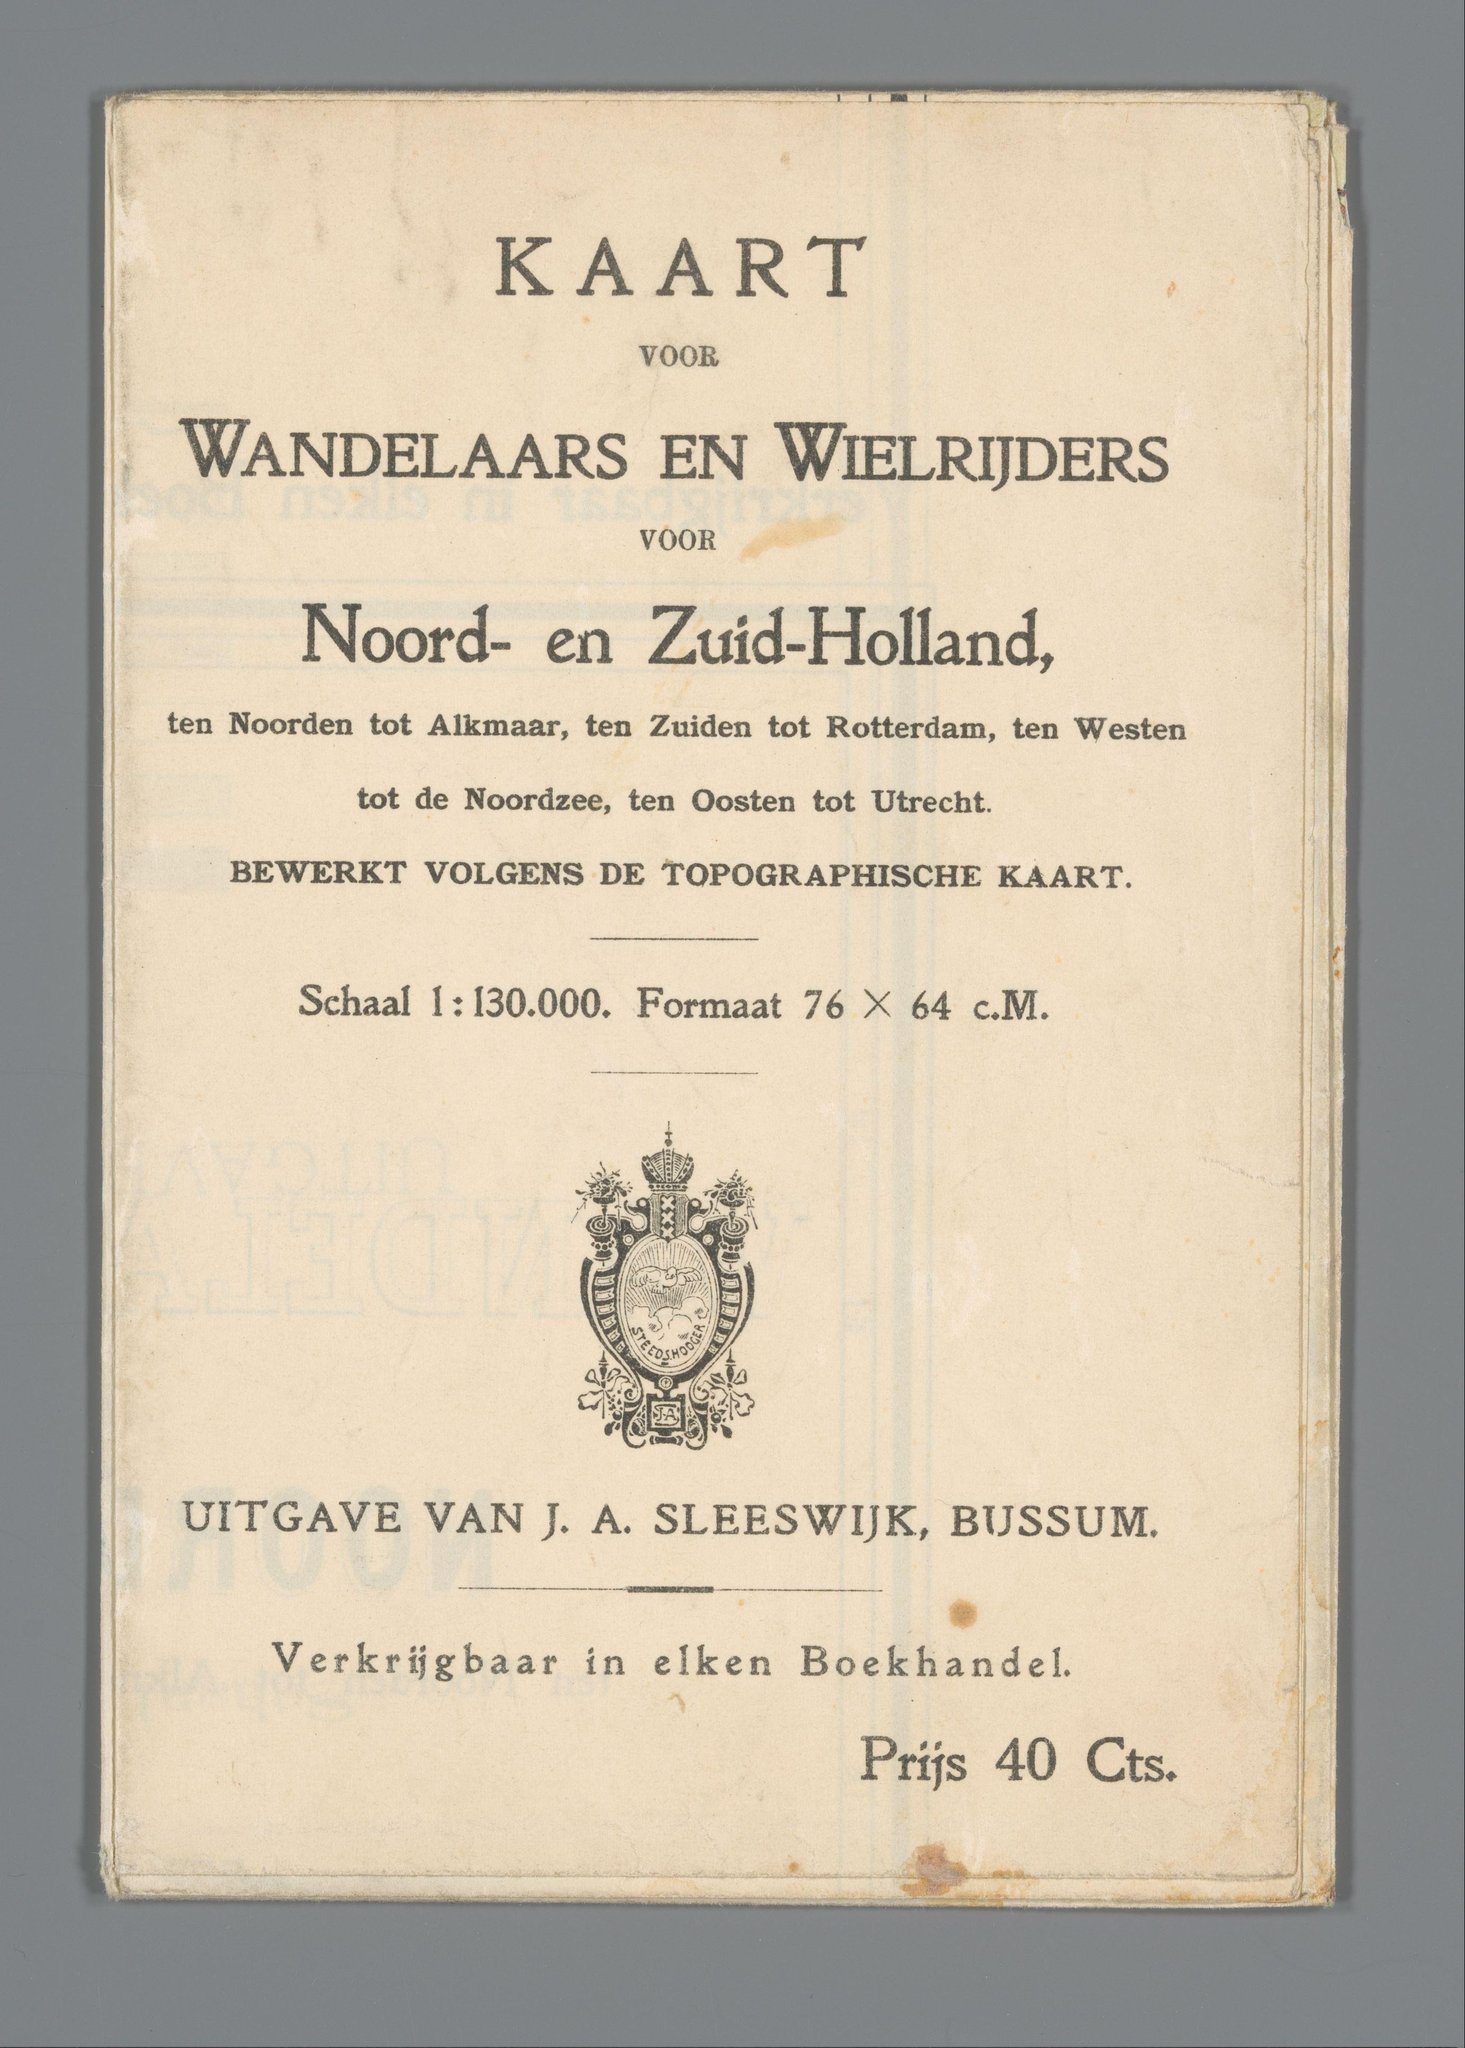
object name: map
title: Kaart van Noord- en Zuid-Holland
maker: j.a. sleeswijk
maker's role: publisher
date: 1930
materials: paper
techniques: lithograph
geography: bussum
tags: maps, atlases